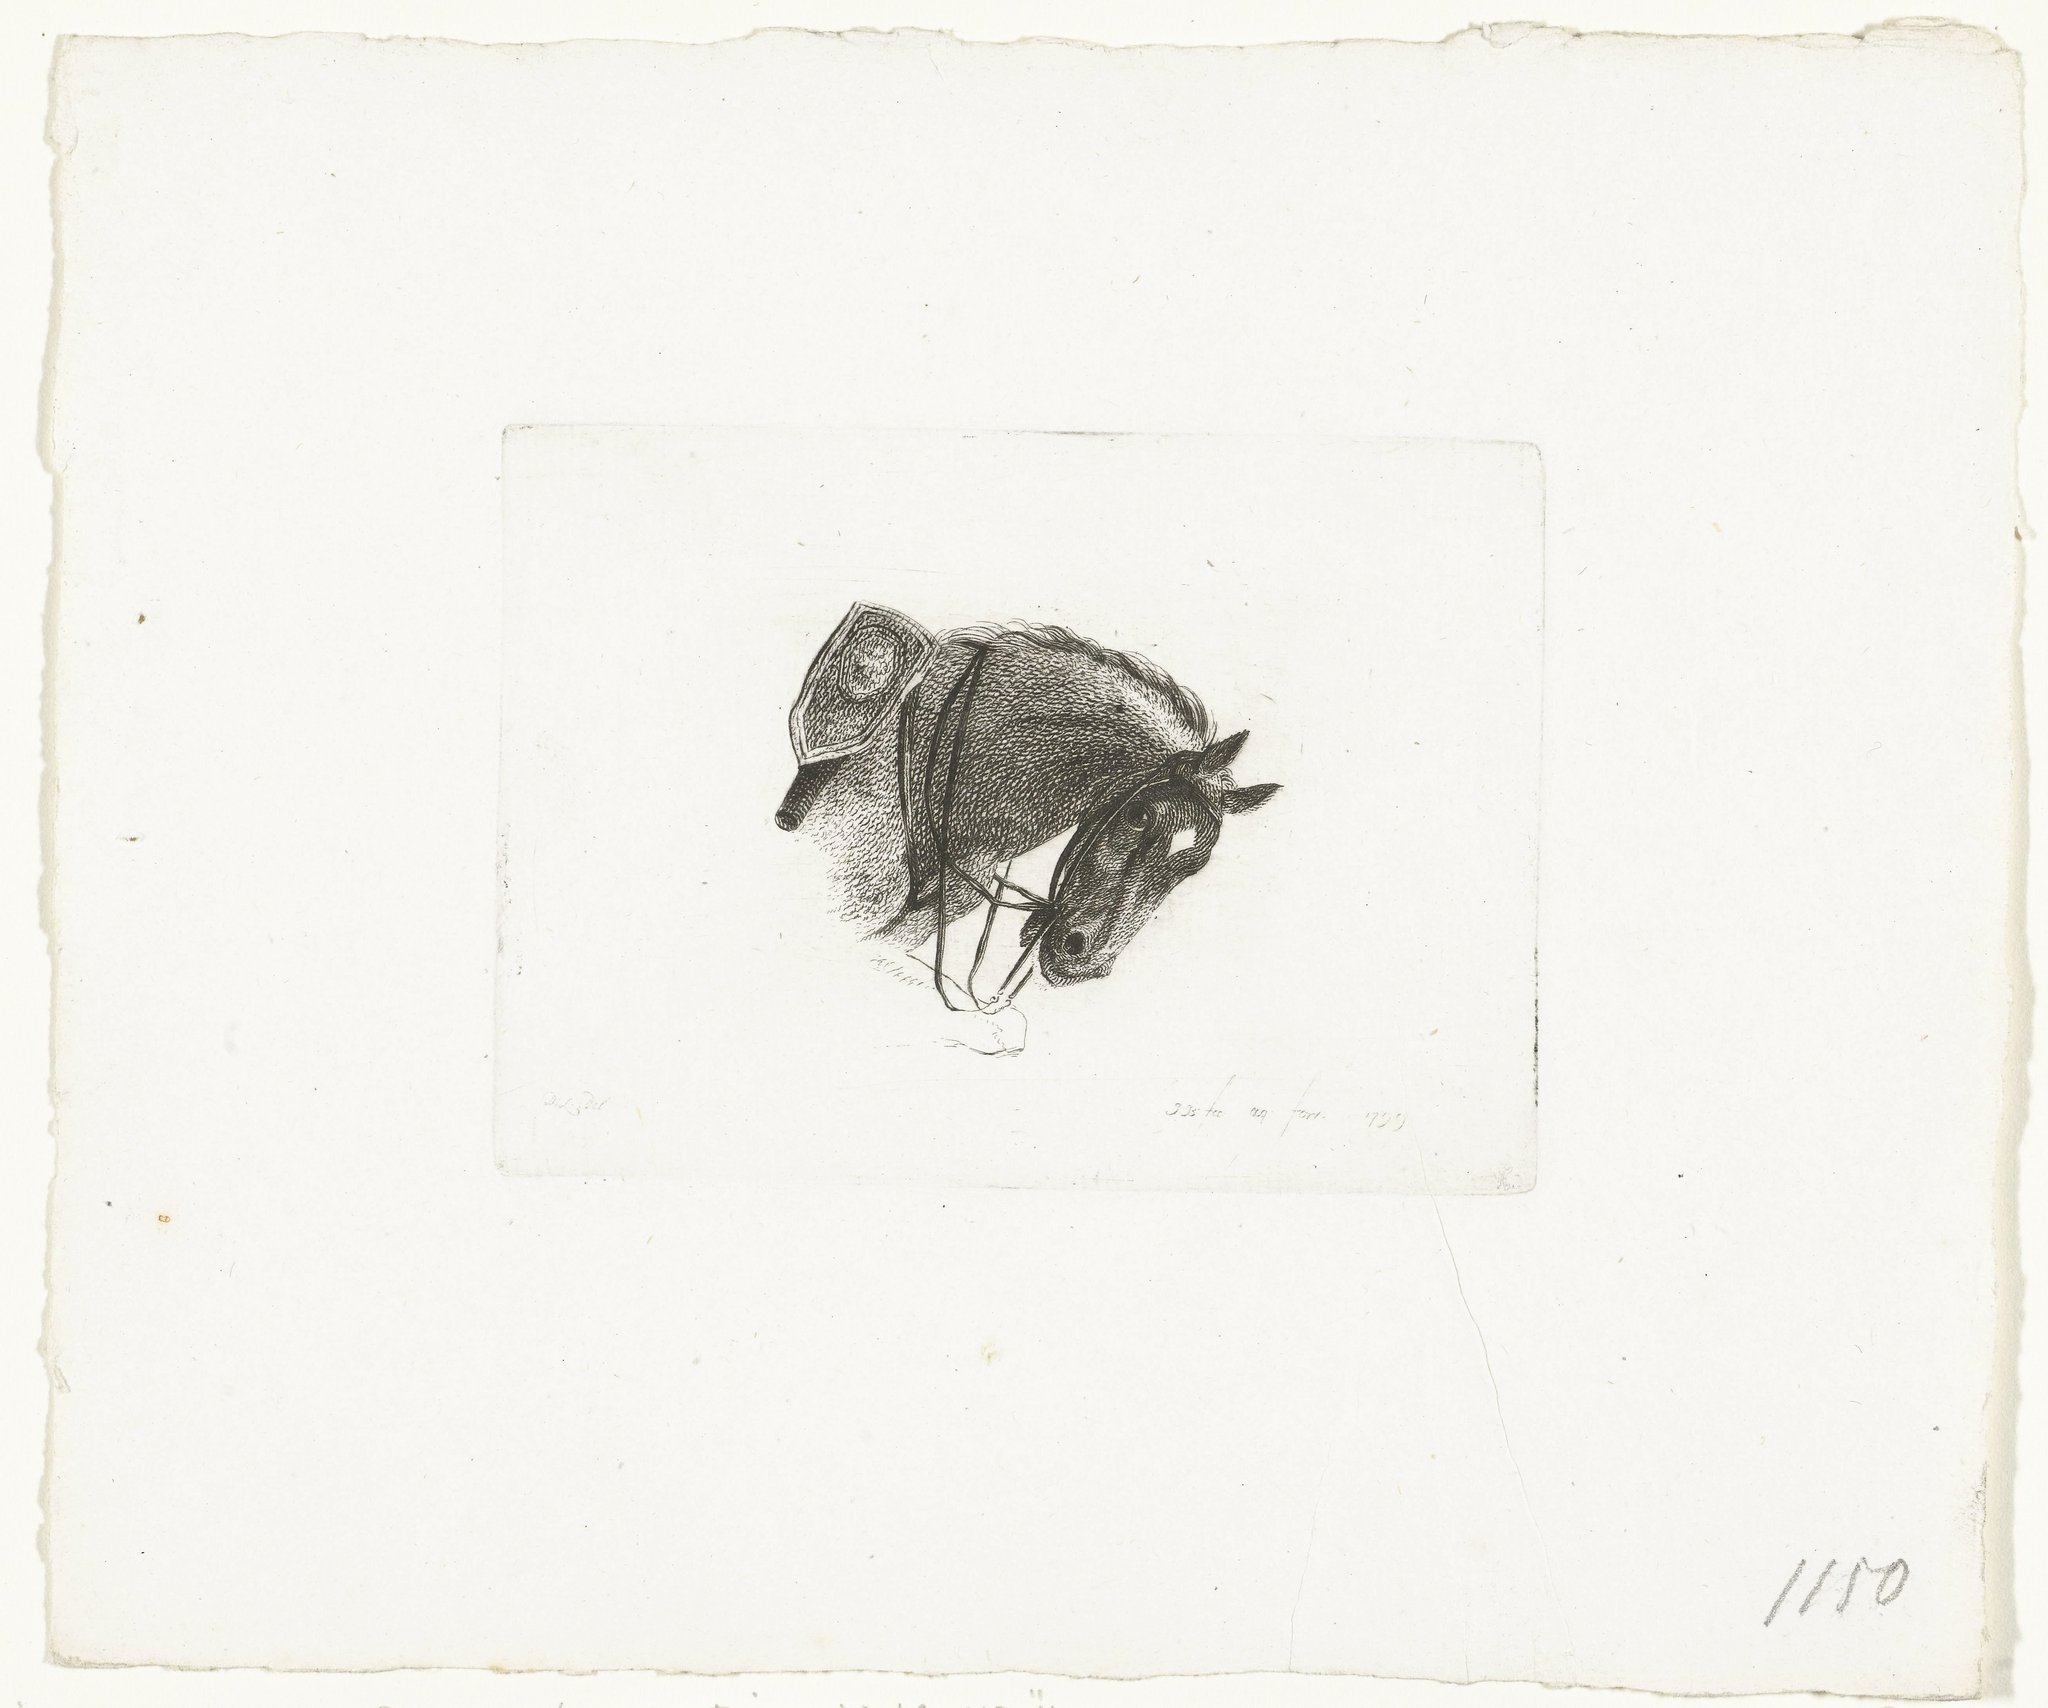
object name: print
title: Paardenhoofden naar Dirk Langendijk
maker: joannes bemme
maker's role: print maker, printer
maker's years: 1775-1841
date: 1800-1841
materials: paper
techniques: etching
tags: horse (+ head of an animal)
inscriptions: collector's mark: Lugt 2228